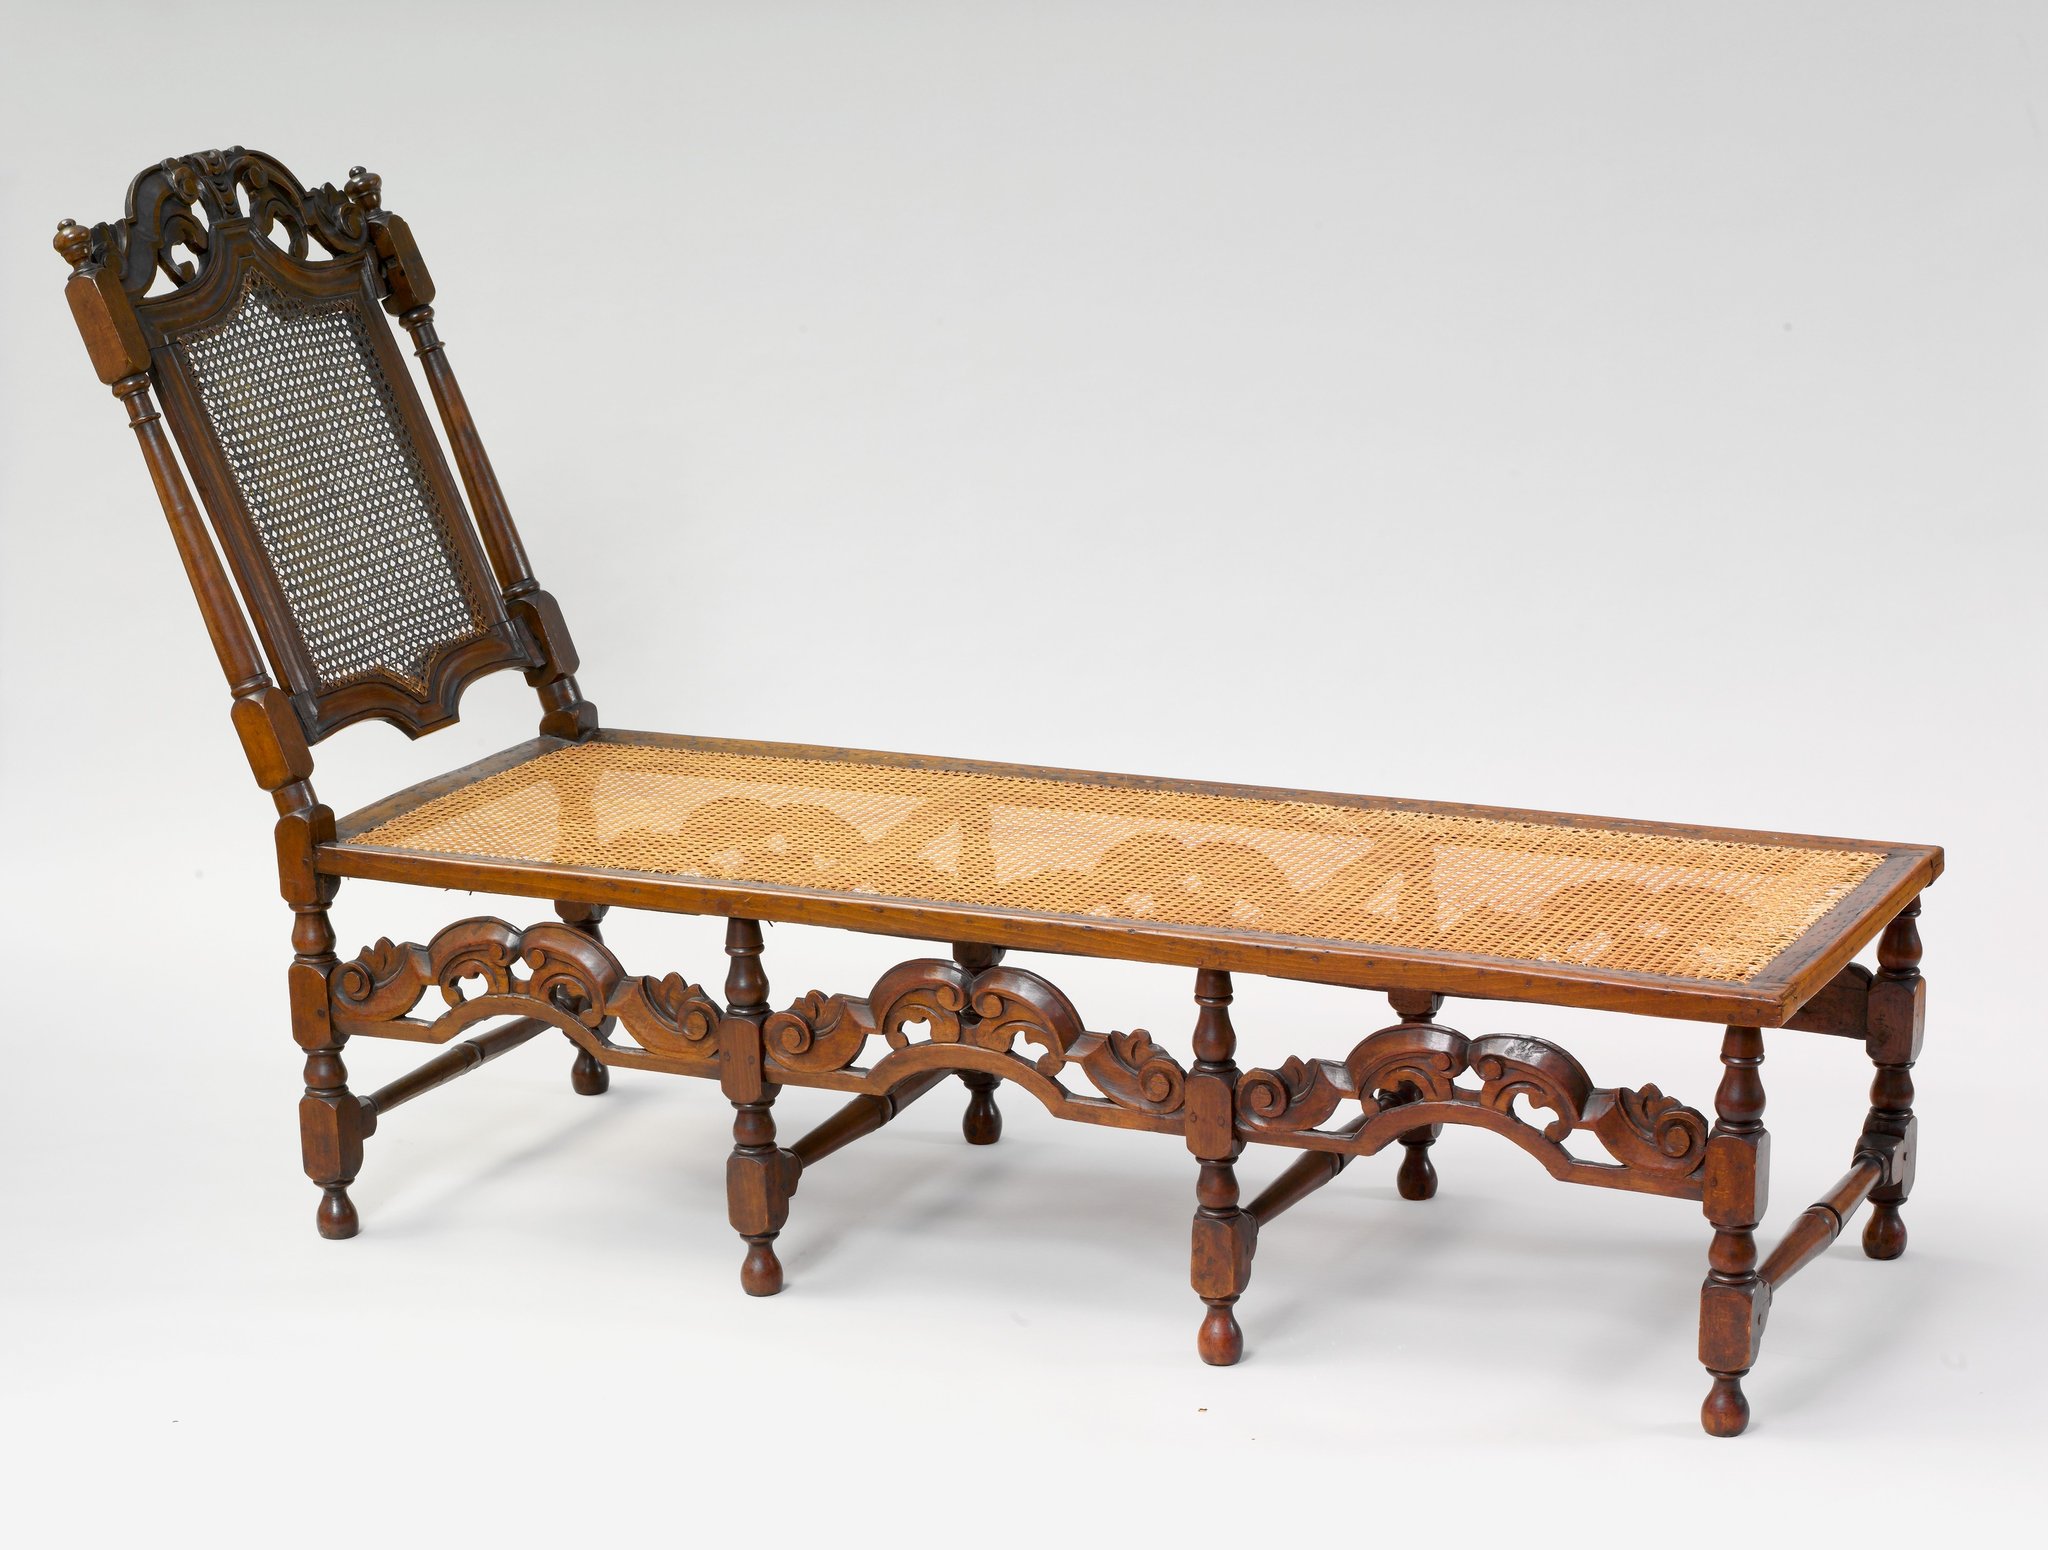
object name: couch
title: Cane couch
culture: american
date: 1690-1710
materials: wood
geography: england